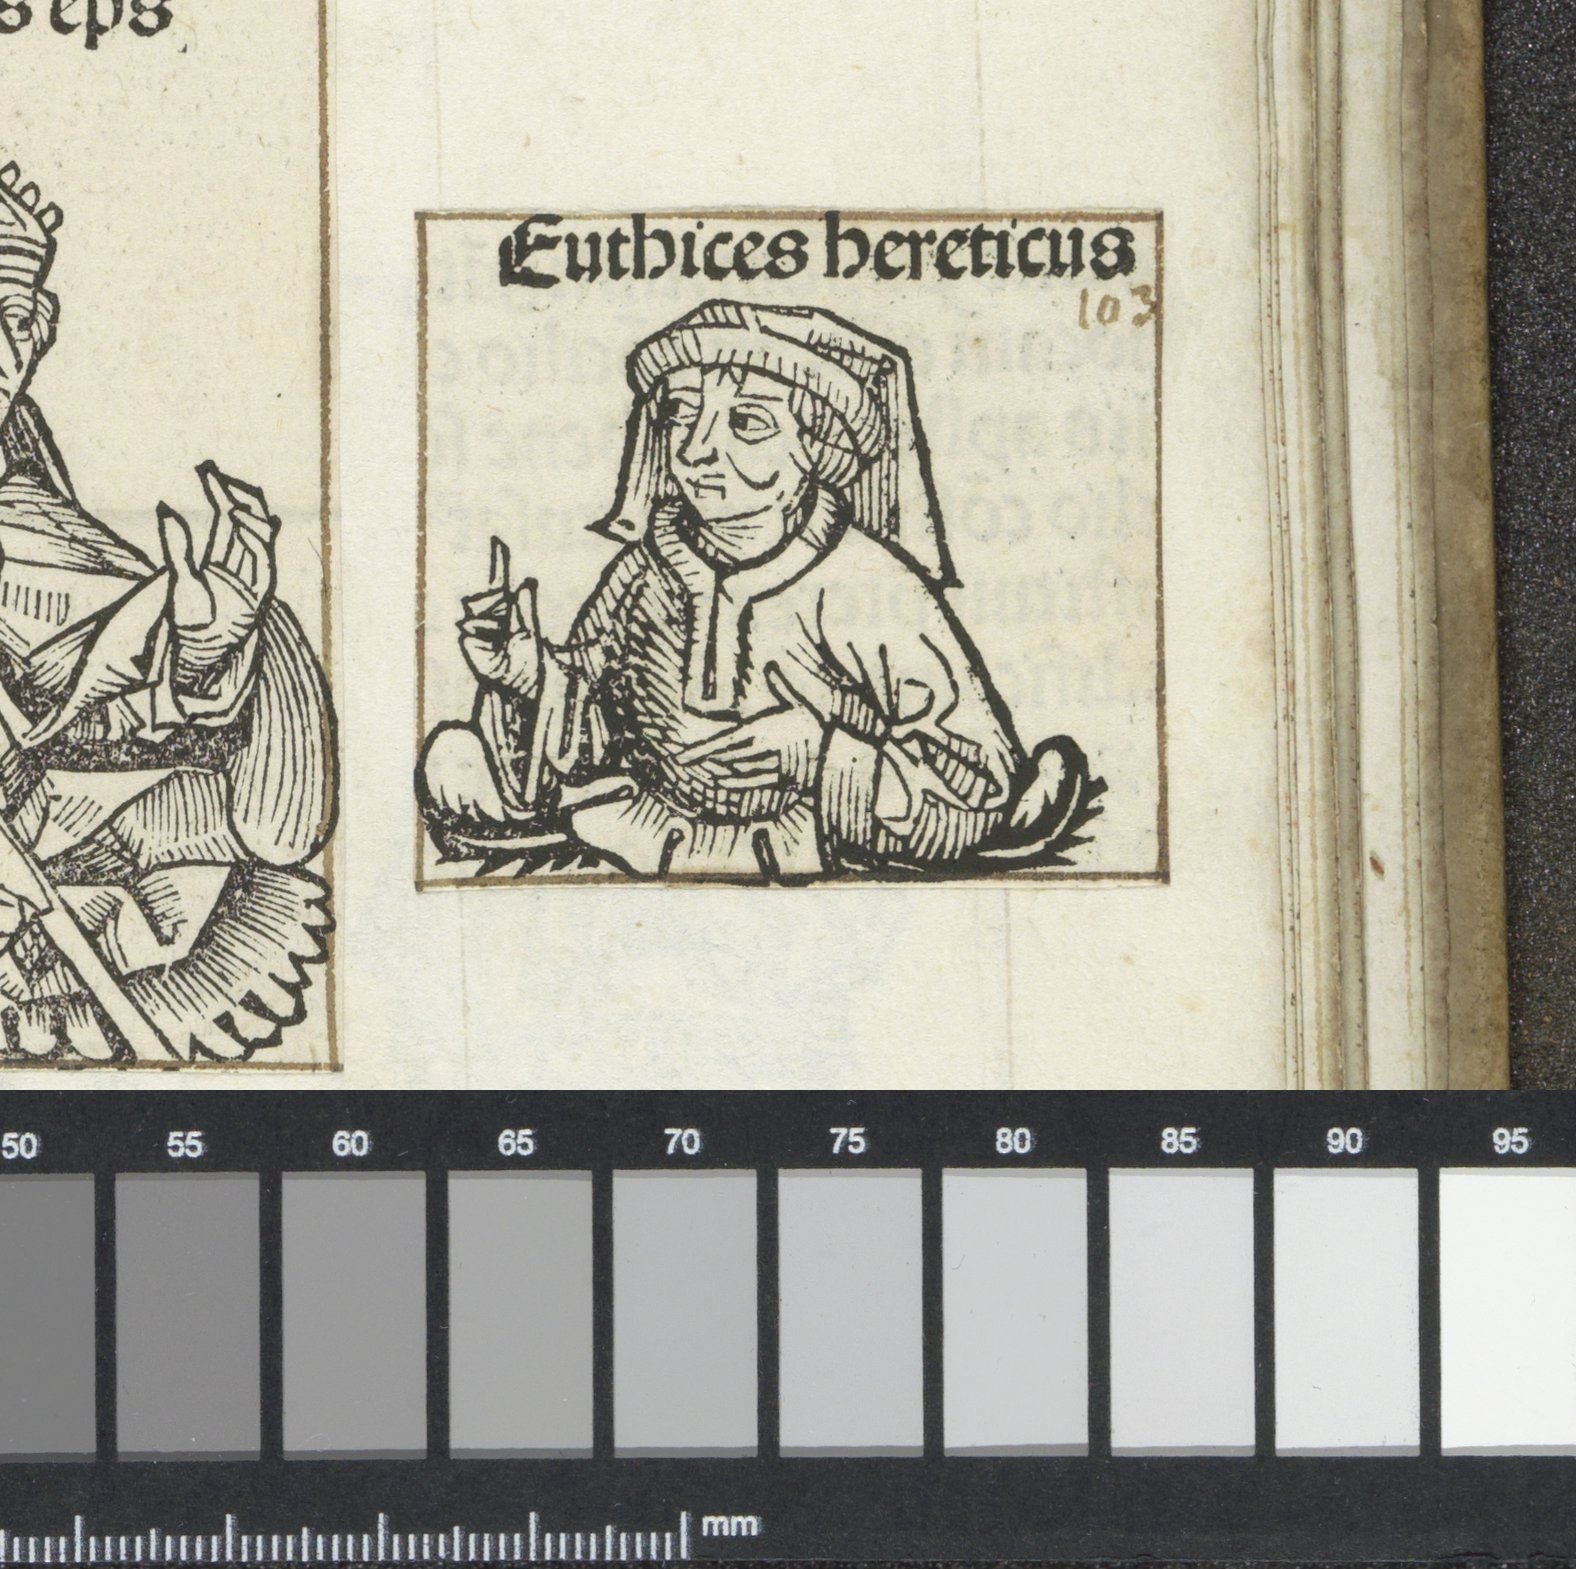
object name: album leaf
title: Eutyches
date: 1493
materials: paper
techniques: letterpress printing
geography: nuremberg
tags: priest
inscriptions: inscription: ‘103’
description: De houtsnede wordt herhaaldelijk gebruikt als boekillustratie in de Liber Chronicarum (of Neurenbergkroniek) van Hartmann Schedel, verschenen in het Latijn en Duits in 1493. Zie de Latijnse uitgave, folio 140v.